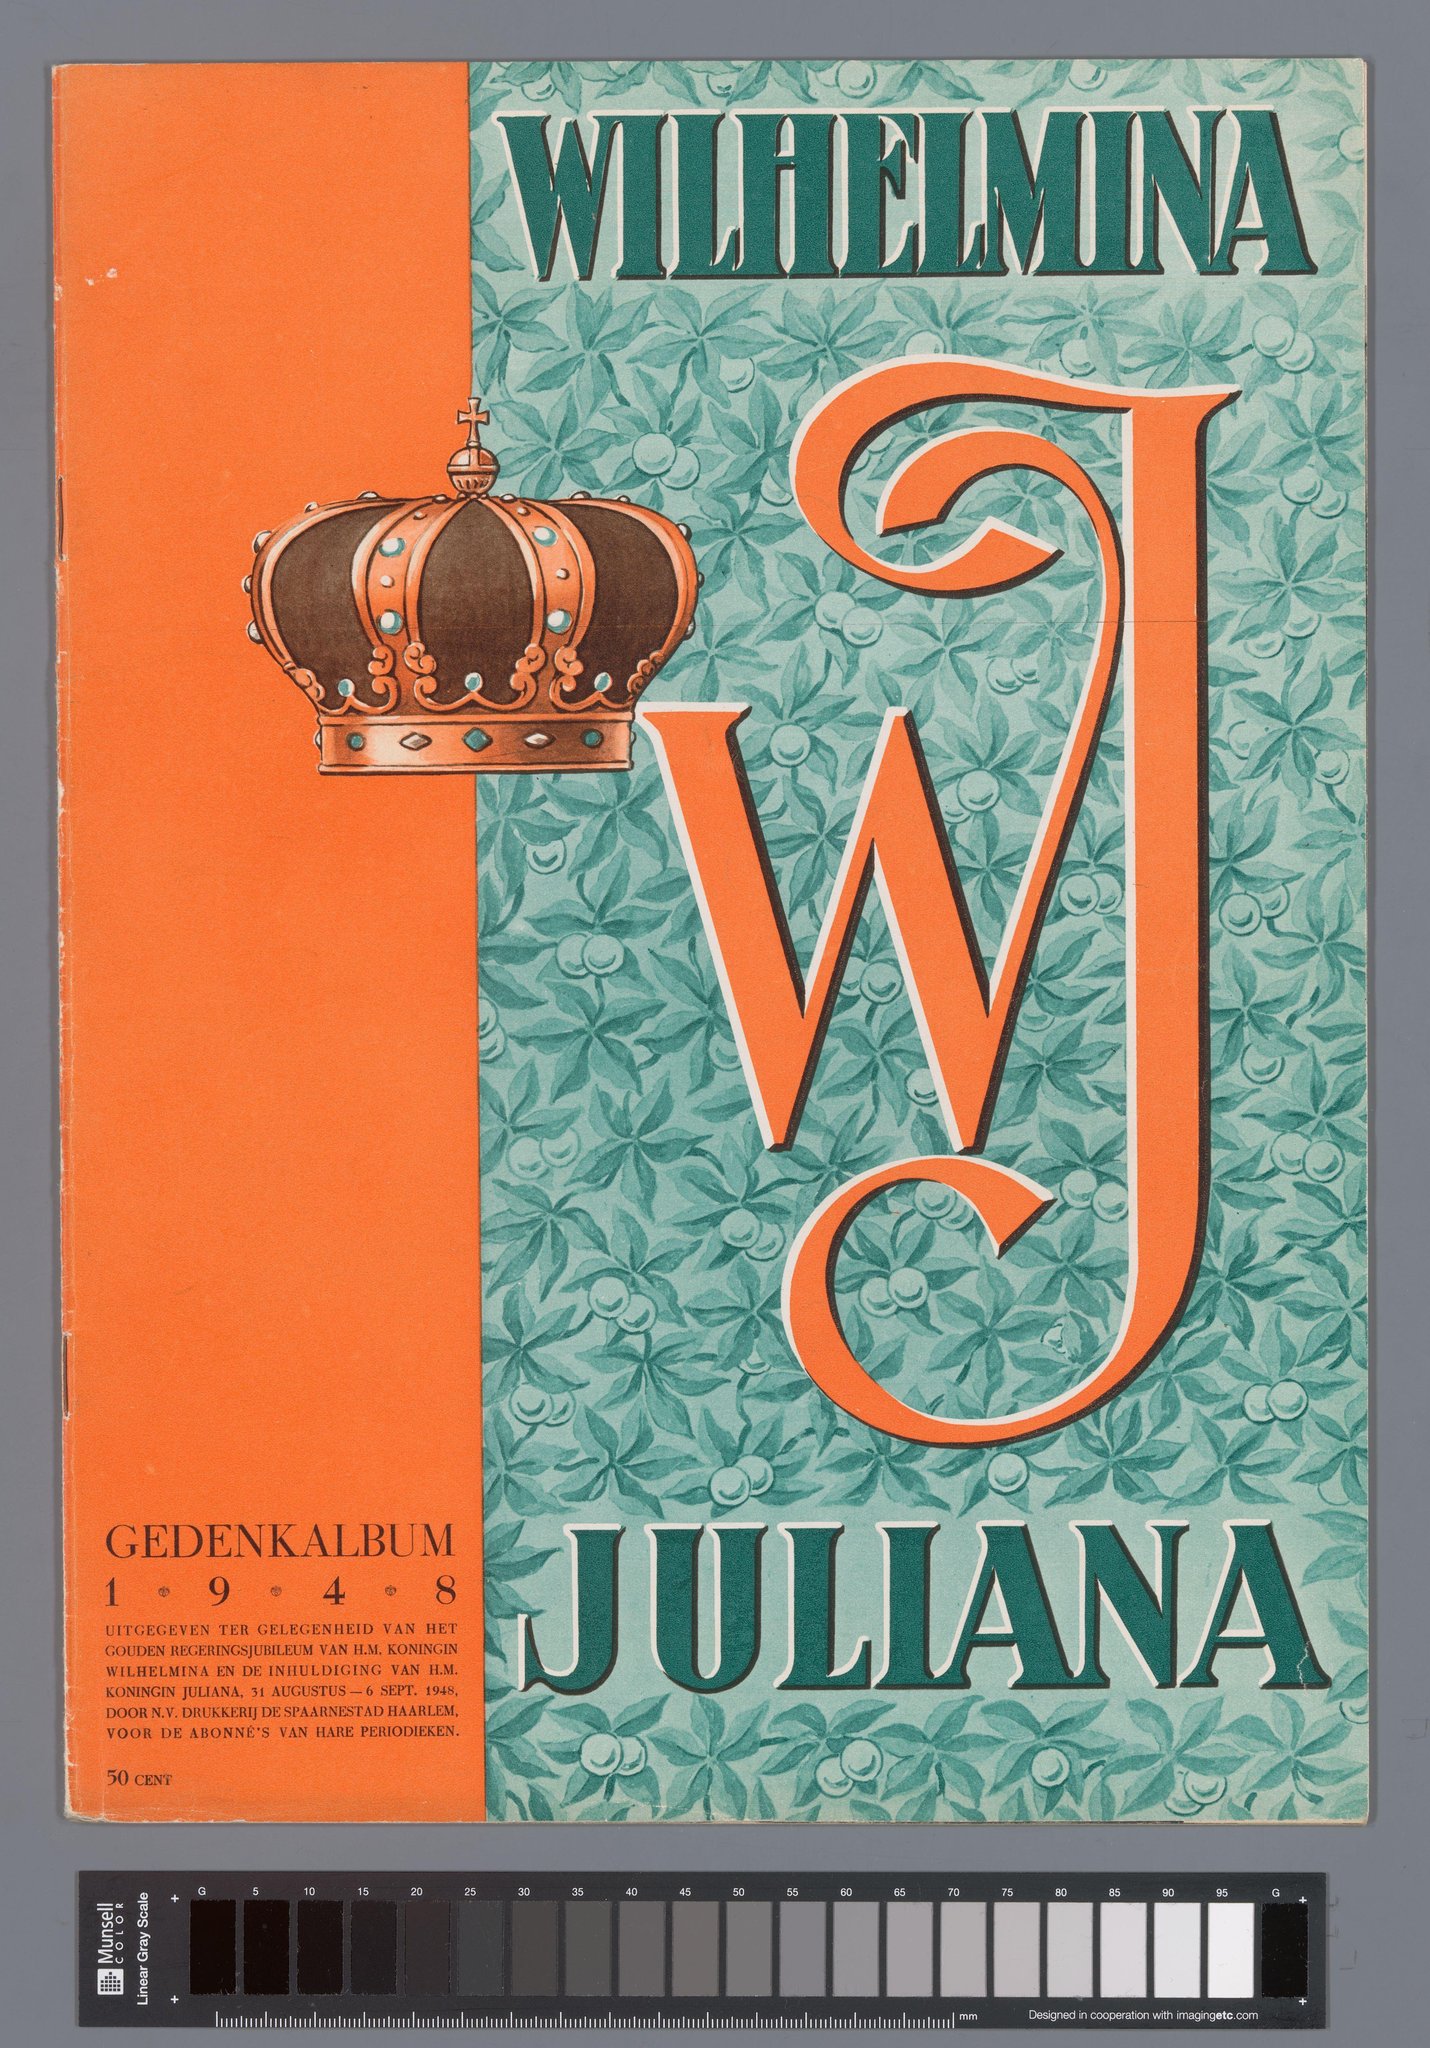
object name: magazine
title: Gedenkalbum 1948: Wilhelmina - Juliana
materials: paper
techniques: printing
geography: haarlem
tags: print maker, wilhelmina of the netherlands, the hague, juliana of the netherlands, netherlands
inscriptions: inscription: ‘WILHELMINA / W J / JULIANA / GEDENKALBUM / 1948’, date: ‘31 AUGUSTUS - 6 SEPT. 1948’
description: Rechthoekig tijdschrift met 31 genummerde pagina's. Op omslag: links een oranje band, verder een kroon en letters WJ in oranje. In groen: het opschrift. Foto's met uitvoerige beschriften. Prijs: 50 cent.